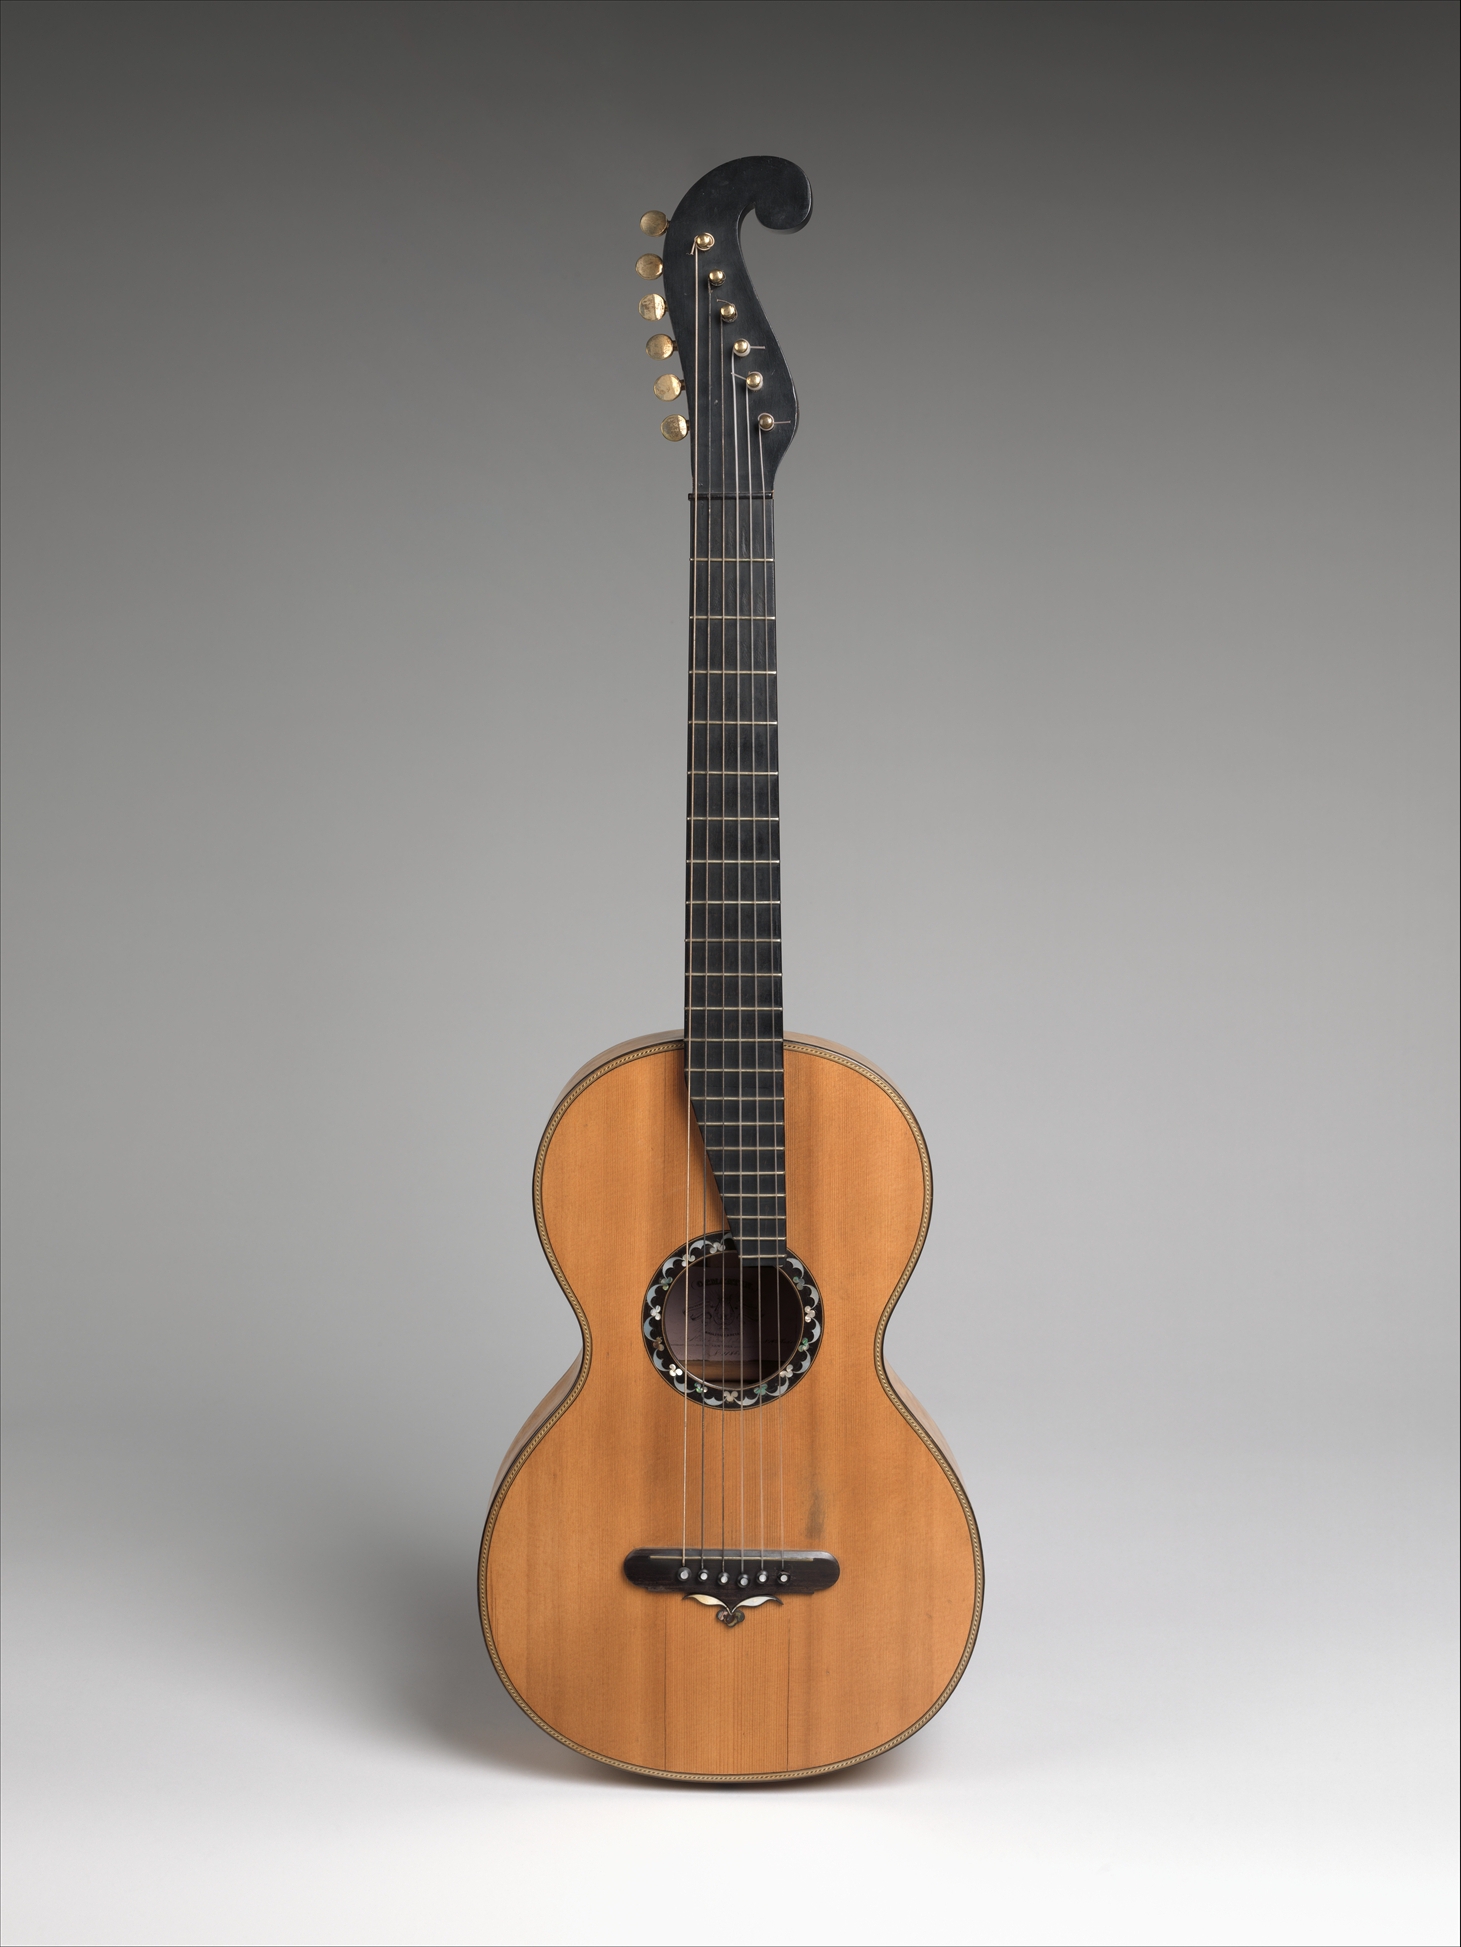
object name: guitar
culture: american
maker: christian frederick martin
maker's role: maker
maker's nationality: american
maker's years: 1796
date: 1838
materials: brass, wood, ivory, metal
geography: united states